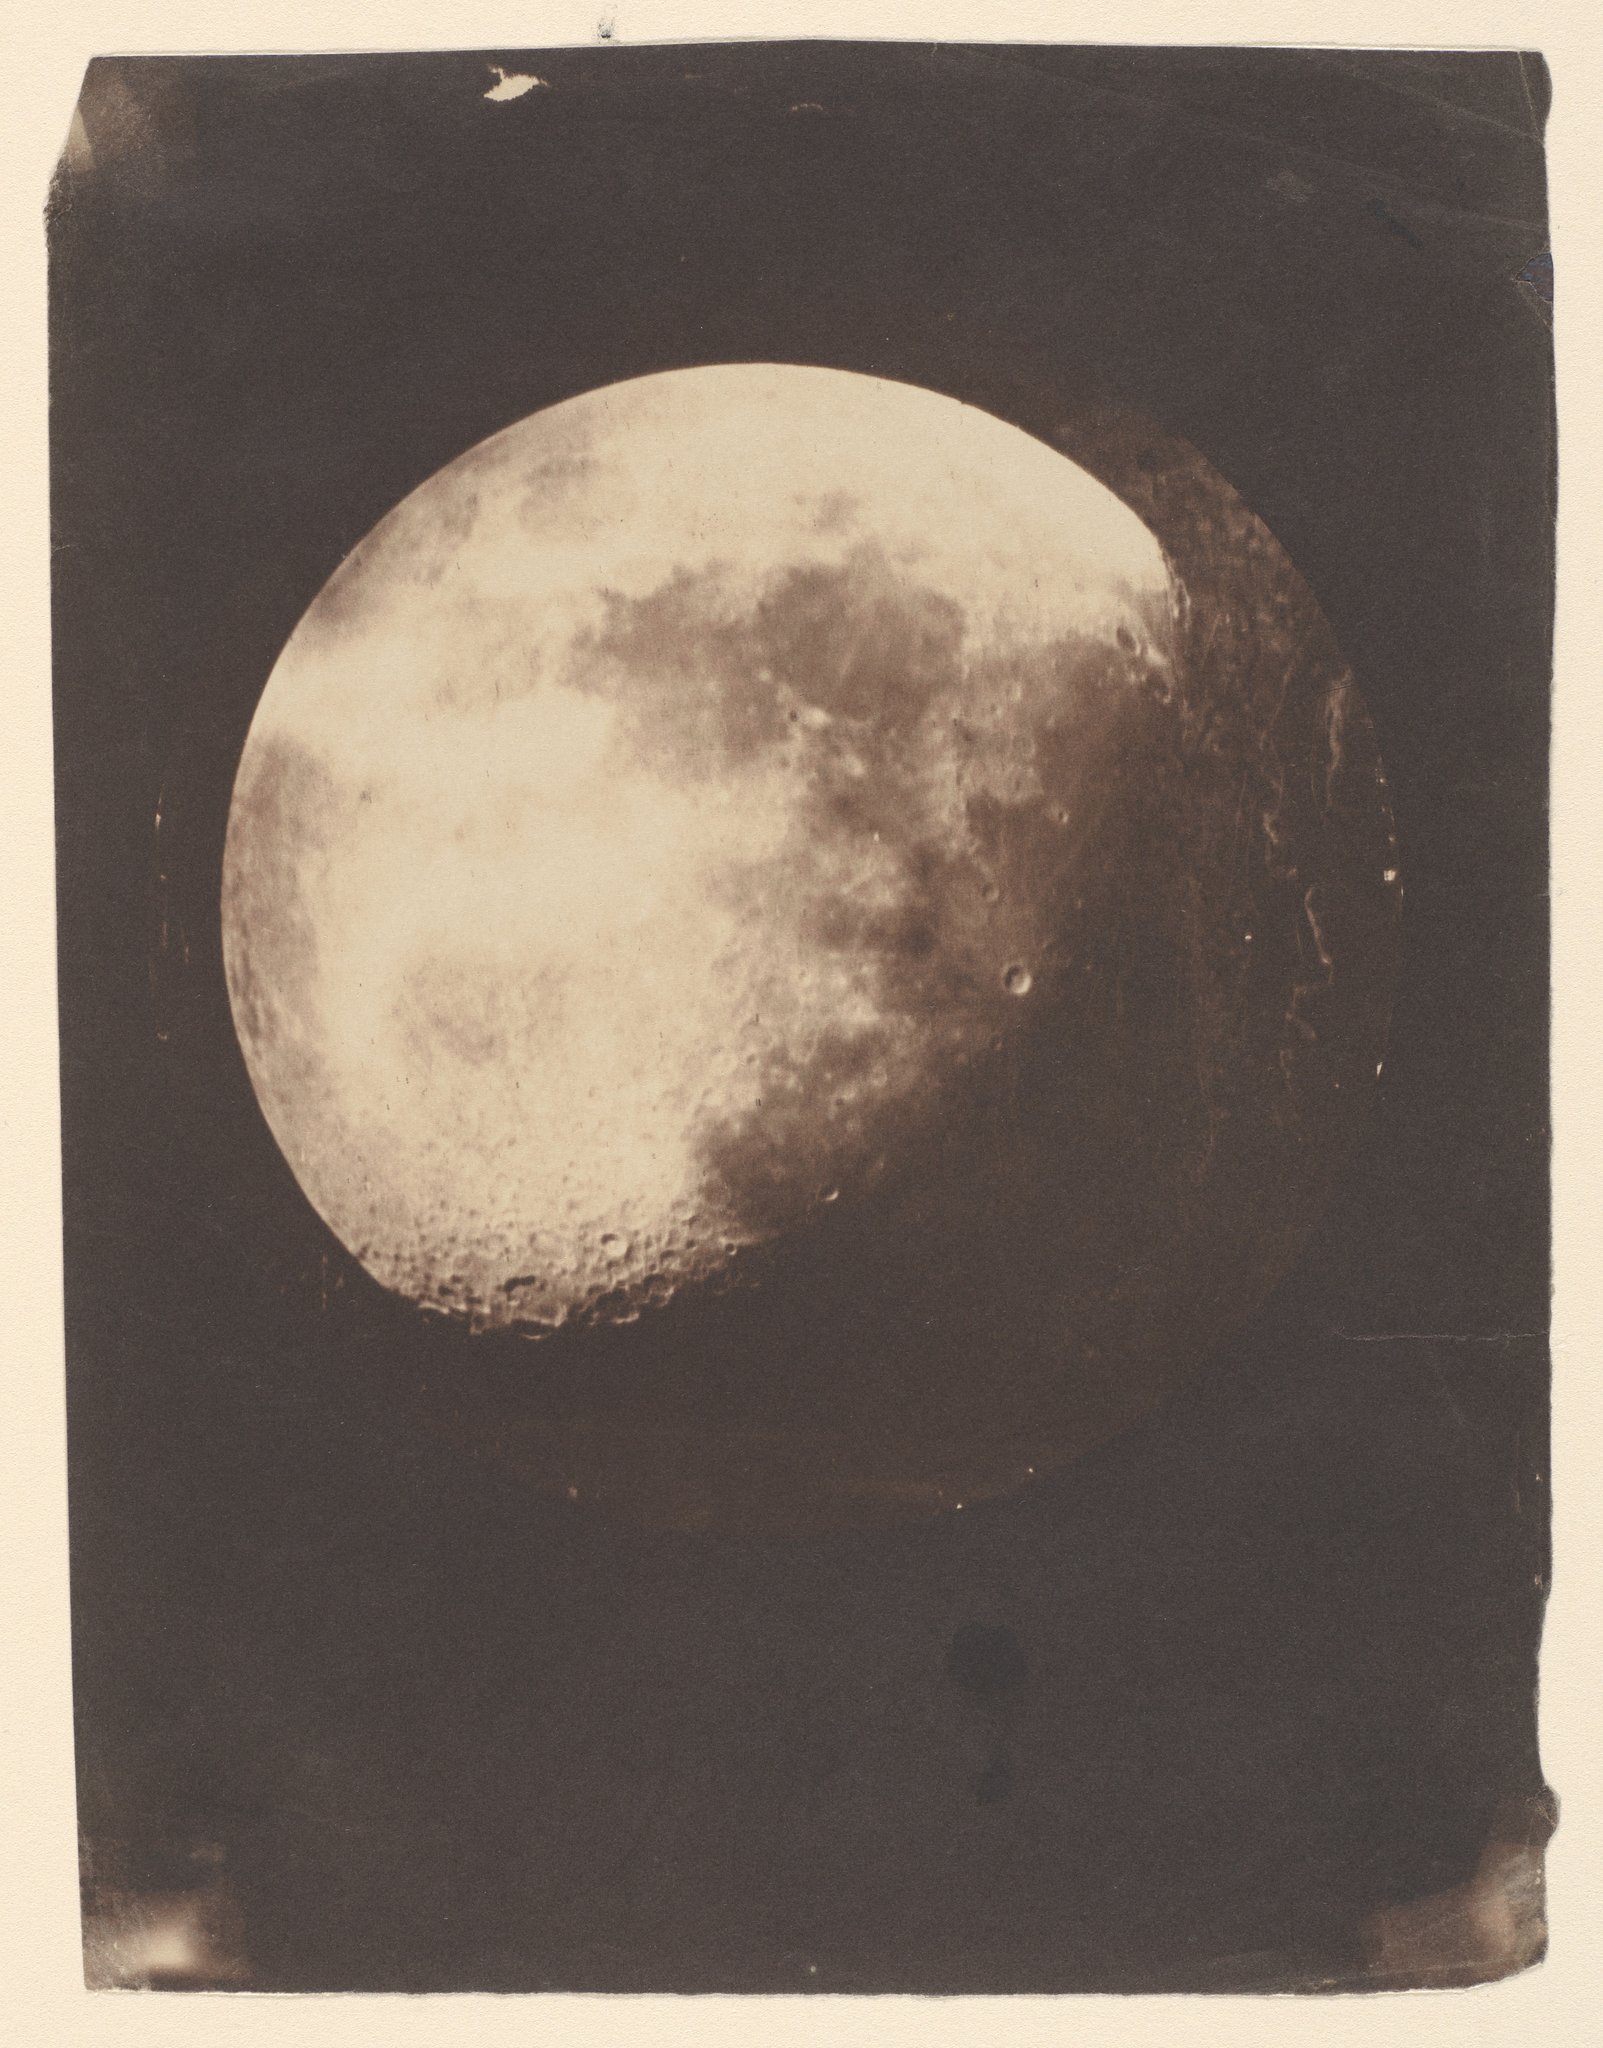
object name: photograph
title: The Moon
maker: john adams whipple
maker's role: artist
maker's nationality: american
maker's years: 1822-1891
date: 1857-1860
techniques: glass negative, salted paper print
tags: moon,astronomy